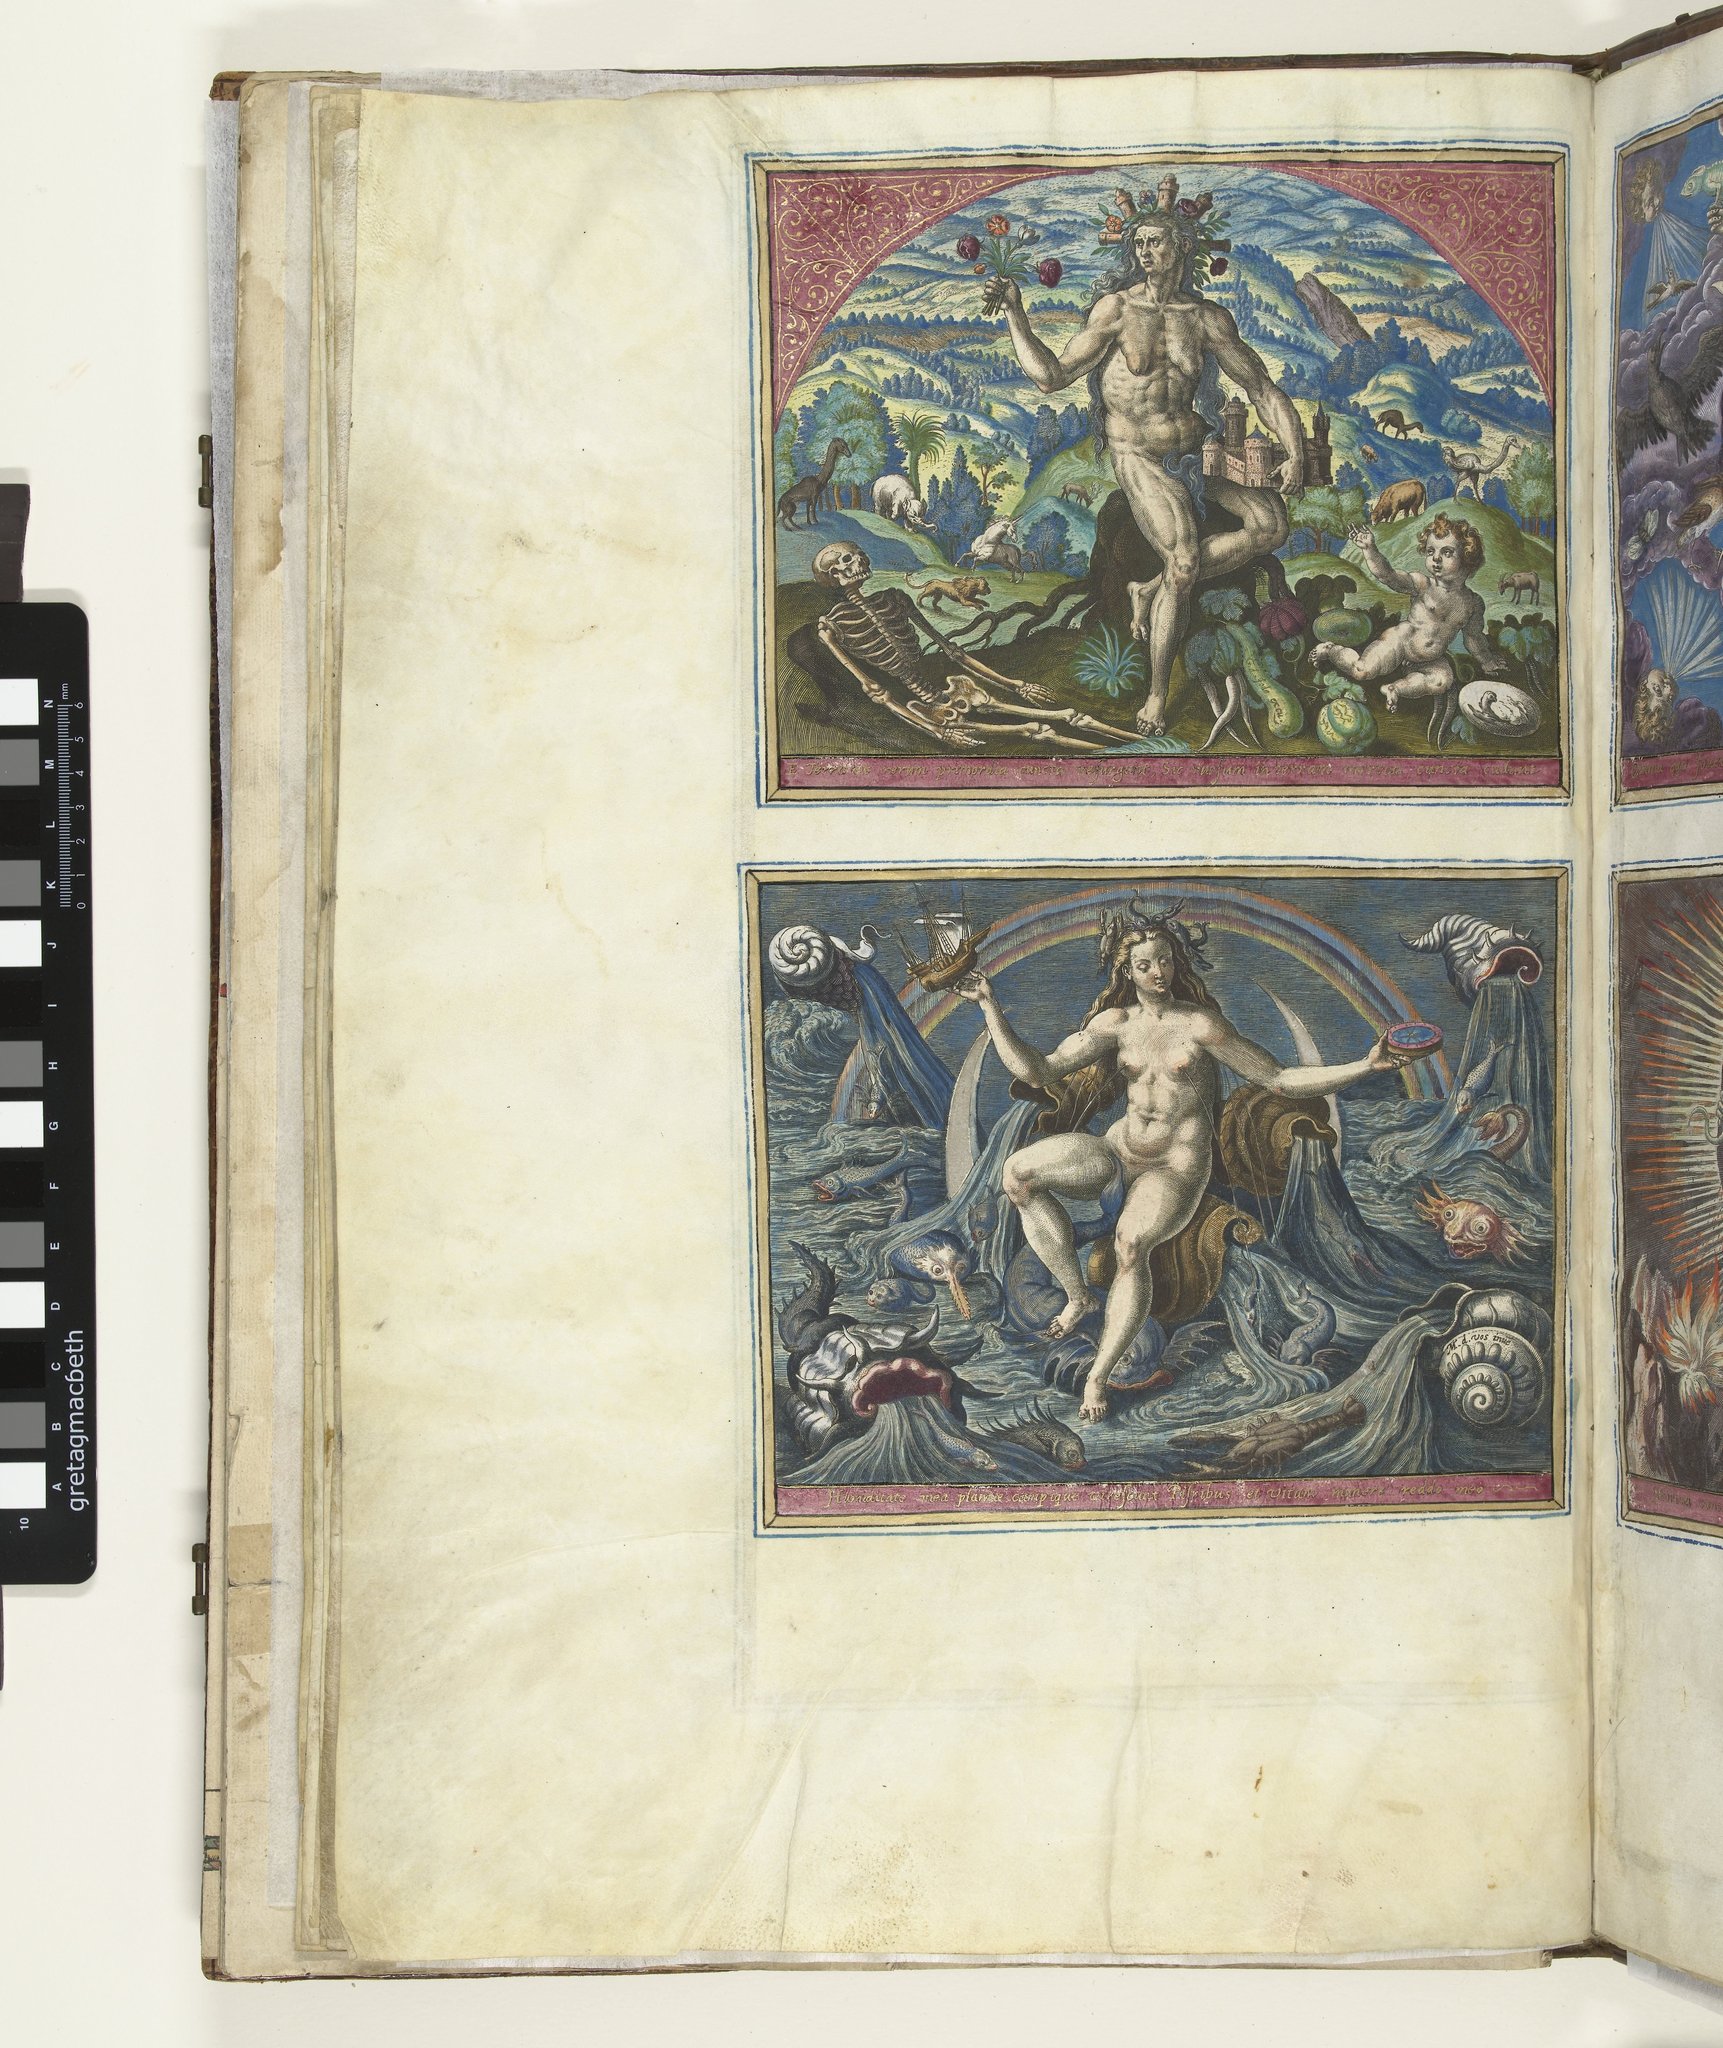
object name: album leaf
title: De vier elementen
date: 1580-1584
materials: paper, parchment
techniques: engraving, hand coloring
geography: antwerp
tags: (story of) cybele, rhea cybele, great mother of the gods (berecynt(h)ia), death as skeleton, young versus old age; young and old, 'terra', 'carro della terra' (ripa)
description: Het element aarde, gepersonifieerd door de naakte godin Cybele. Cybele draagt een muurkroon en houdt een bos bloemen in haar ene hand en in haar andere hand een maquette van een stad. Ze is omringd door de vruchten van de aarde en de personificaties van leven en dood, respectievelijk een pasgeborene en een skelet. Op de achtergrond de dieren van de aarde in een weids landschap. Onder de voorstelling een vers in het Latijn. Deze prent maakt deel uit van een album.